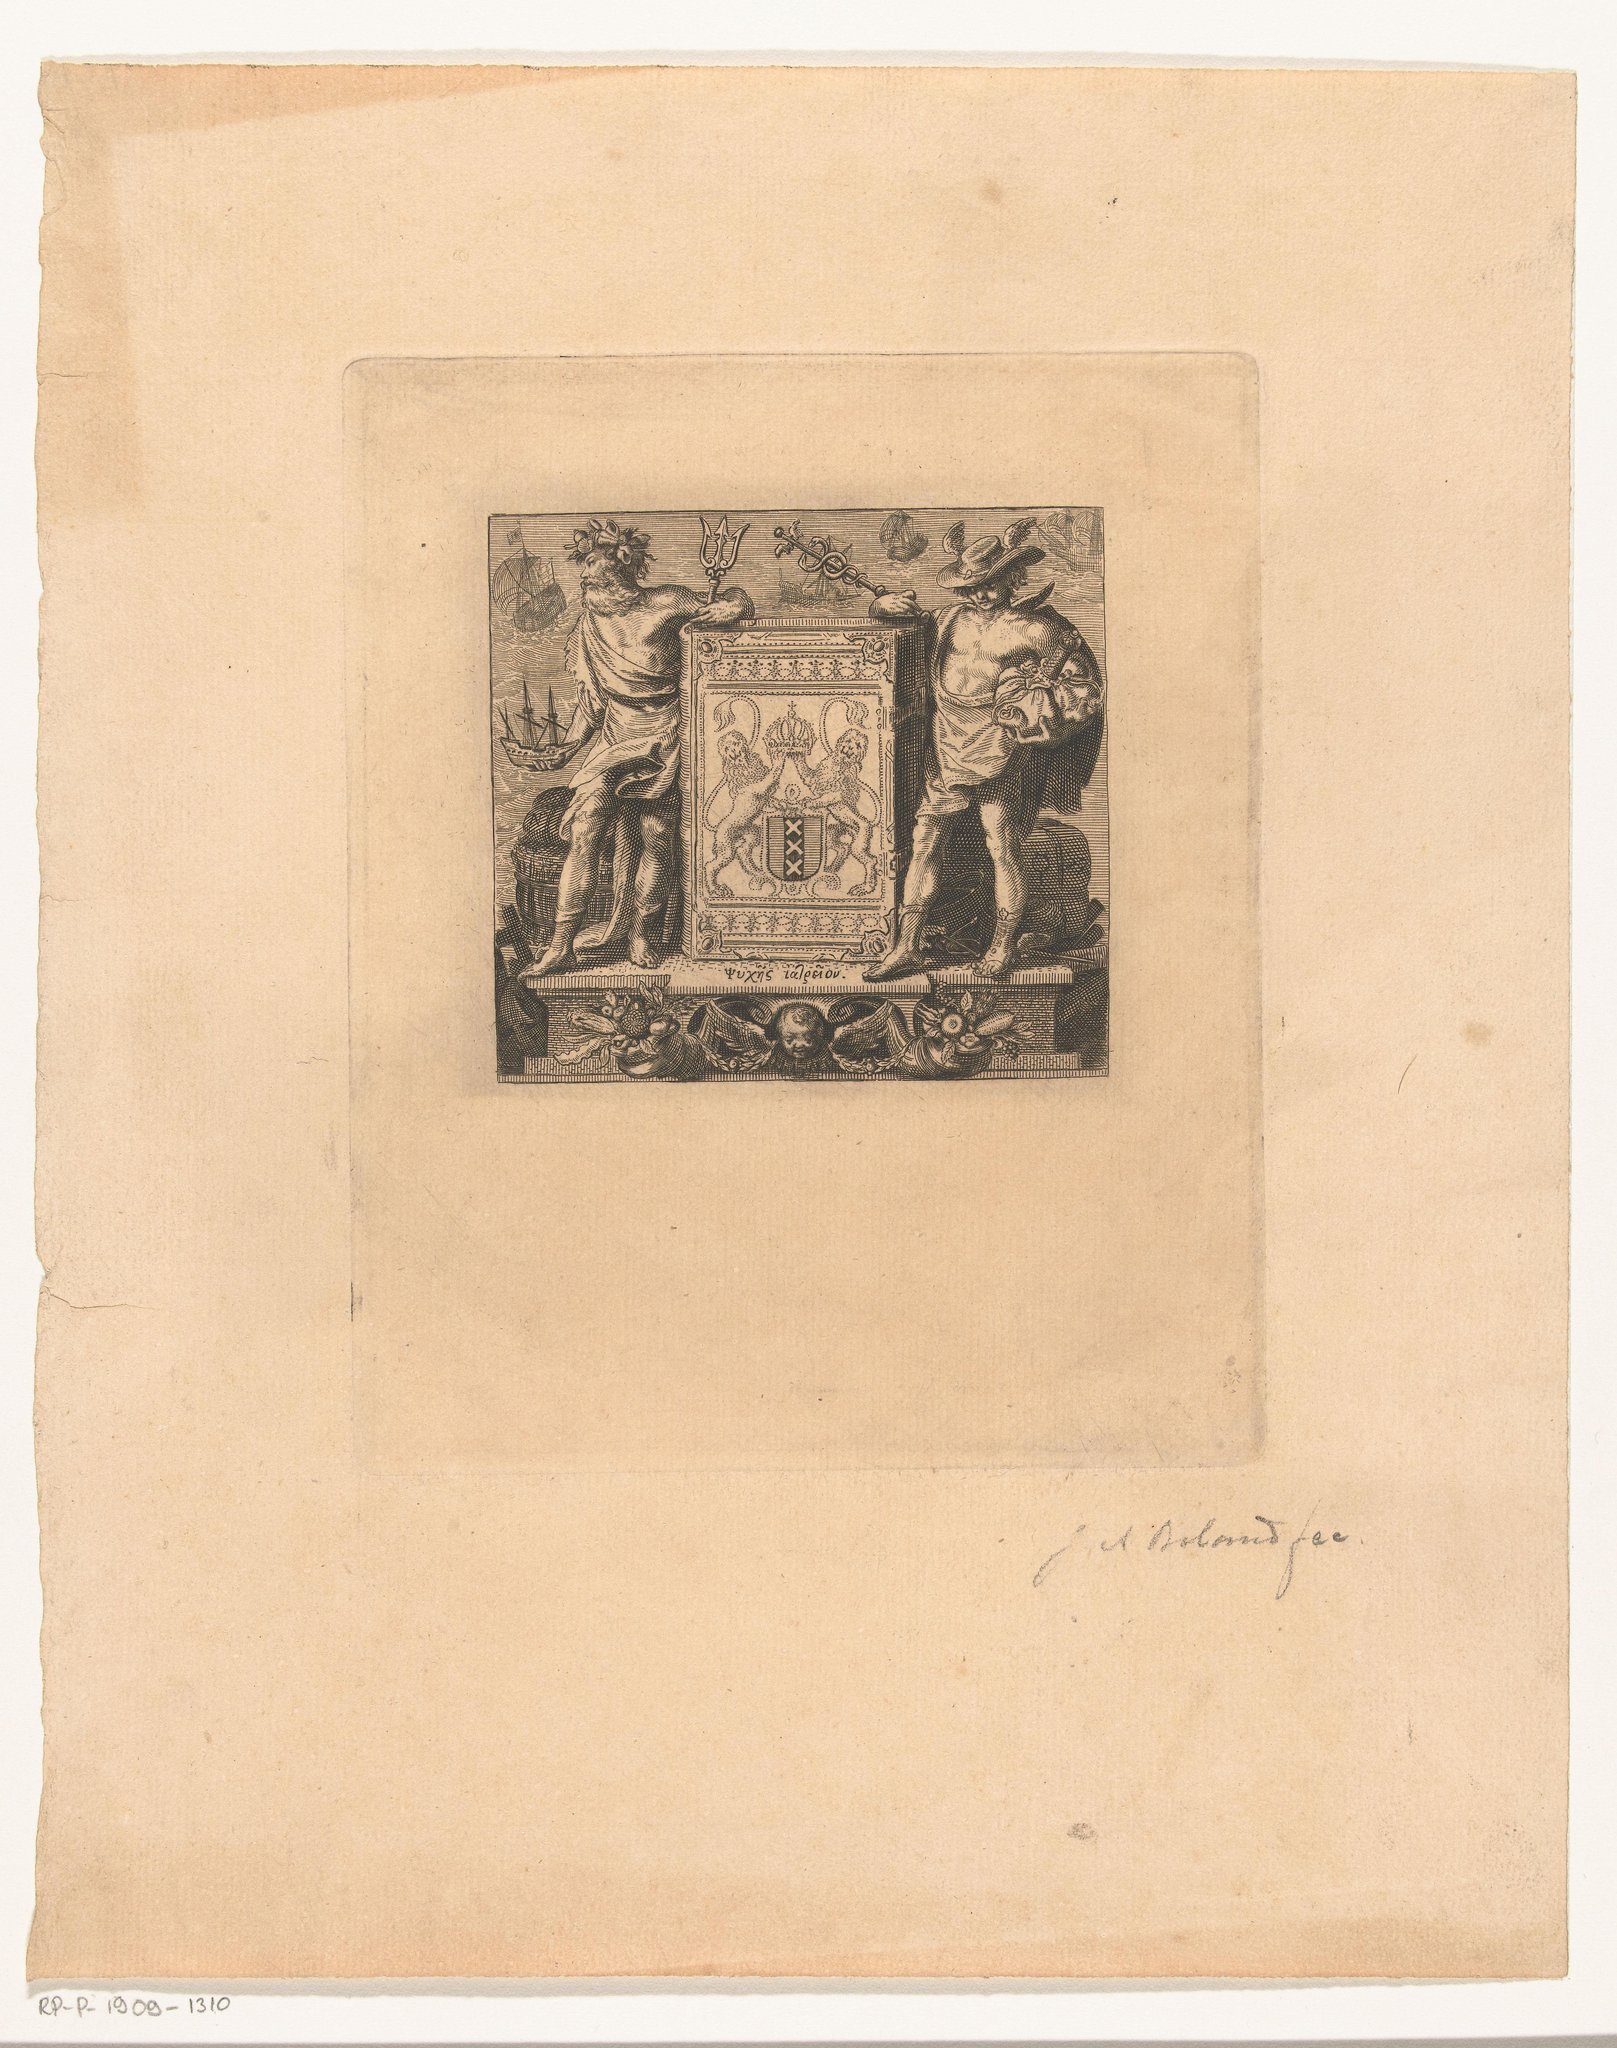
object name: print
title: Titelvignet met Neptunus en Mercurius aan weerszijden van het wapen van Amsterdam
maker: johannes arnoldus boland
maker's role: print maker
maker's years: 1838-1922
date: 1860-1900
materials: paper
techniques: engraving, etching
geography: amsterdam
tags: (story of) neptune (poseidon), coat of arms (as symbol of the state, etc.) (+ city; municipal), (story of) mercury (hermes)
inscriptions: collector's mark: Lugt 2228, signature: ‘J.A. Boland fec.’